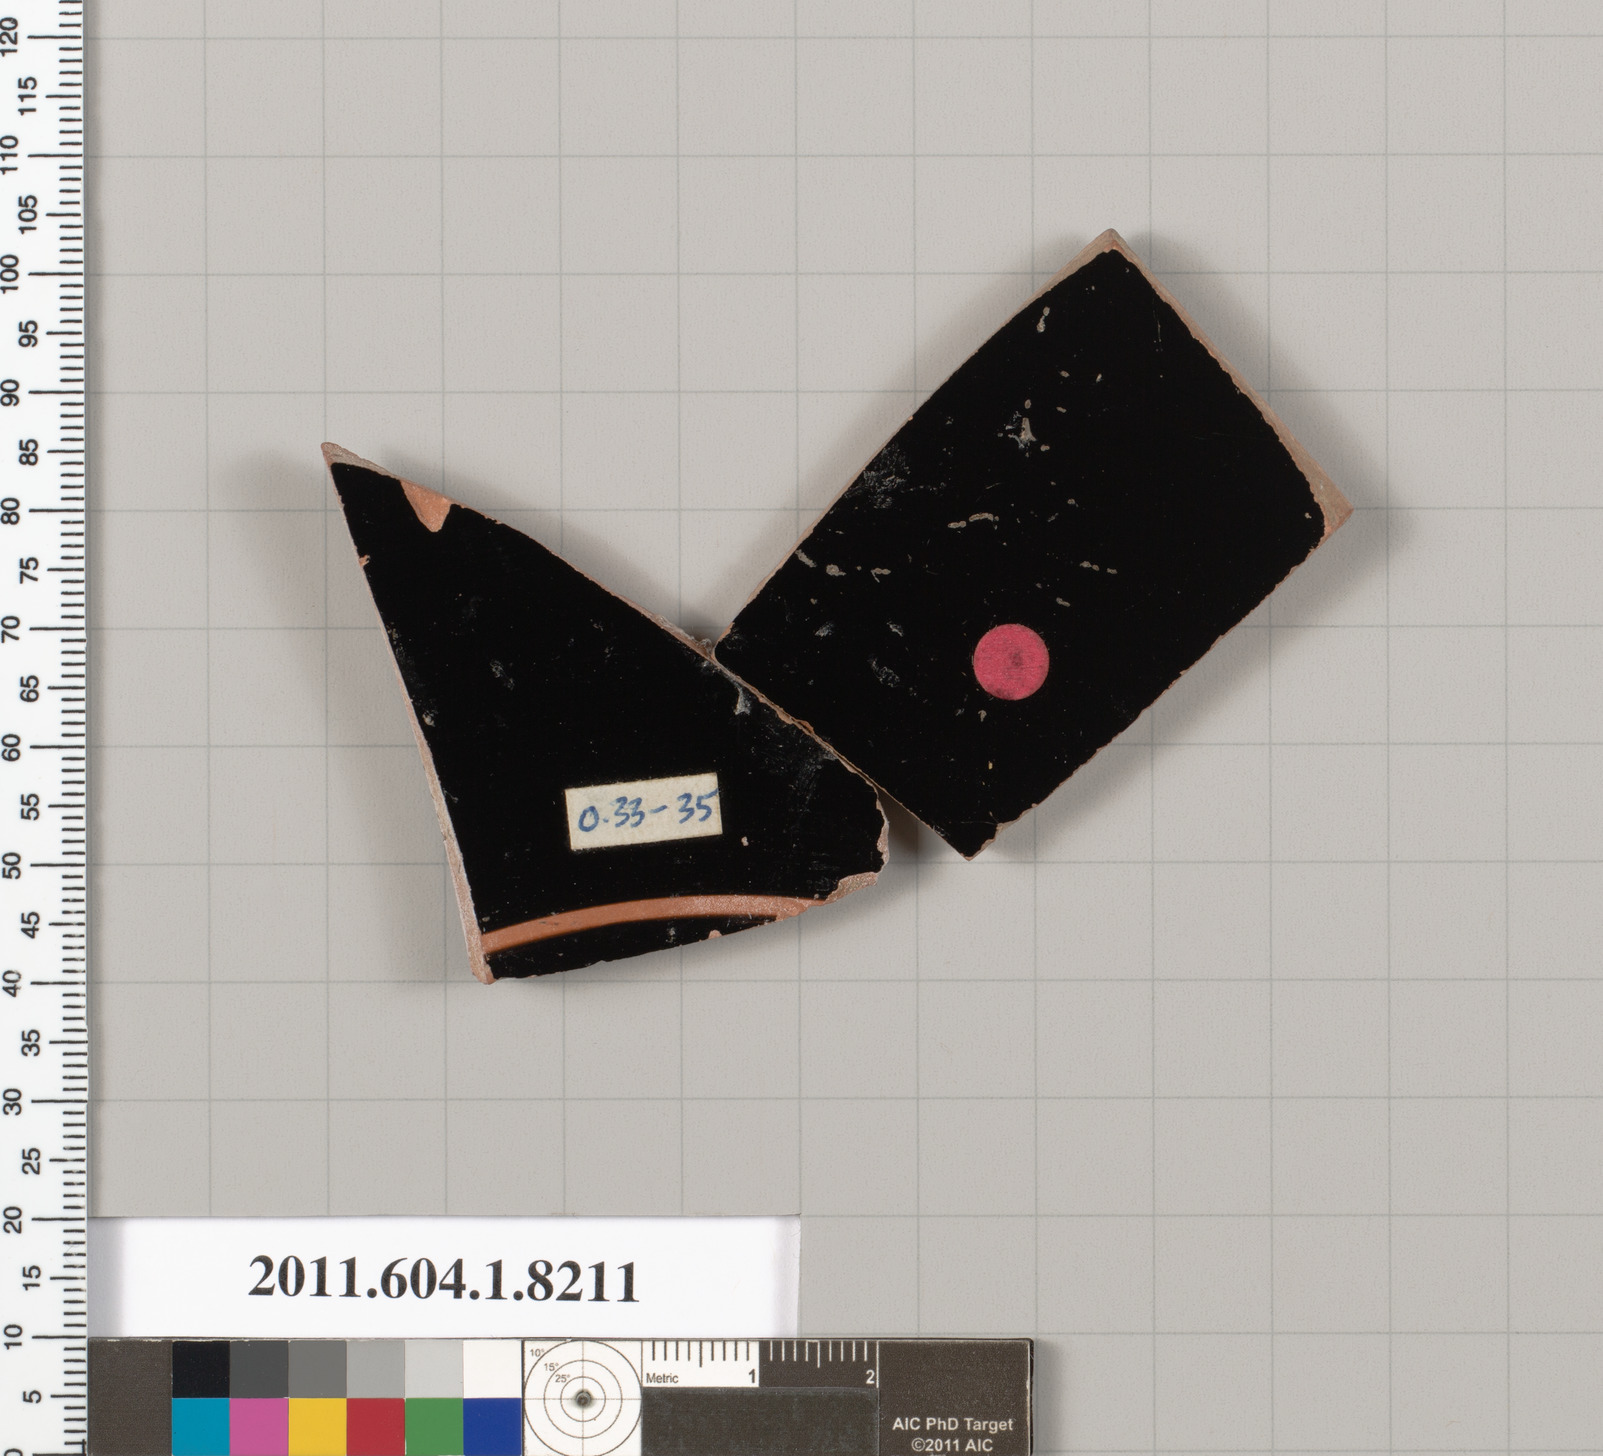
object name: kylix fragment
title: Terracotta fragment of a kylix (drinking cup)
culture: greek, attic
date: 520-510 BCE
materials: terracotta